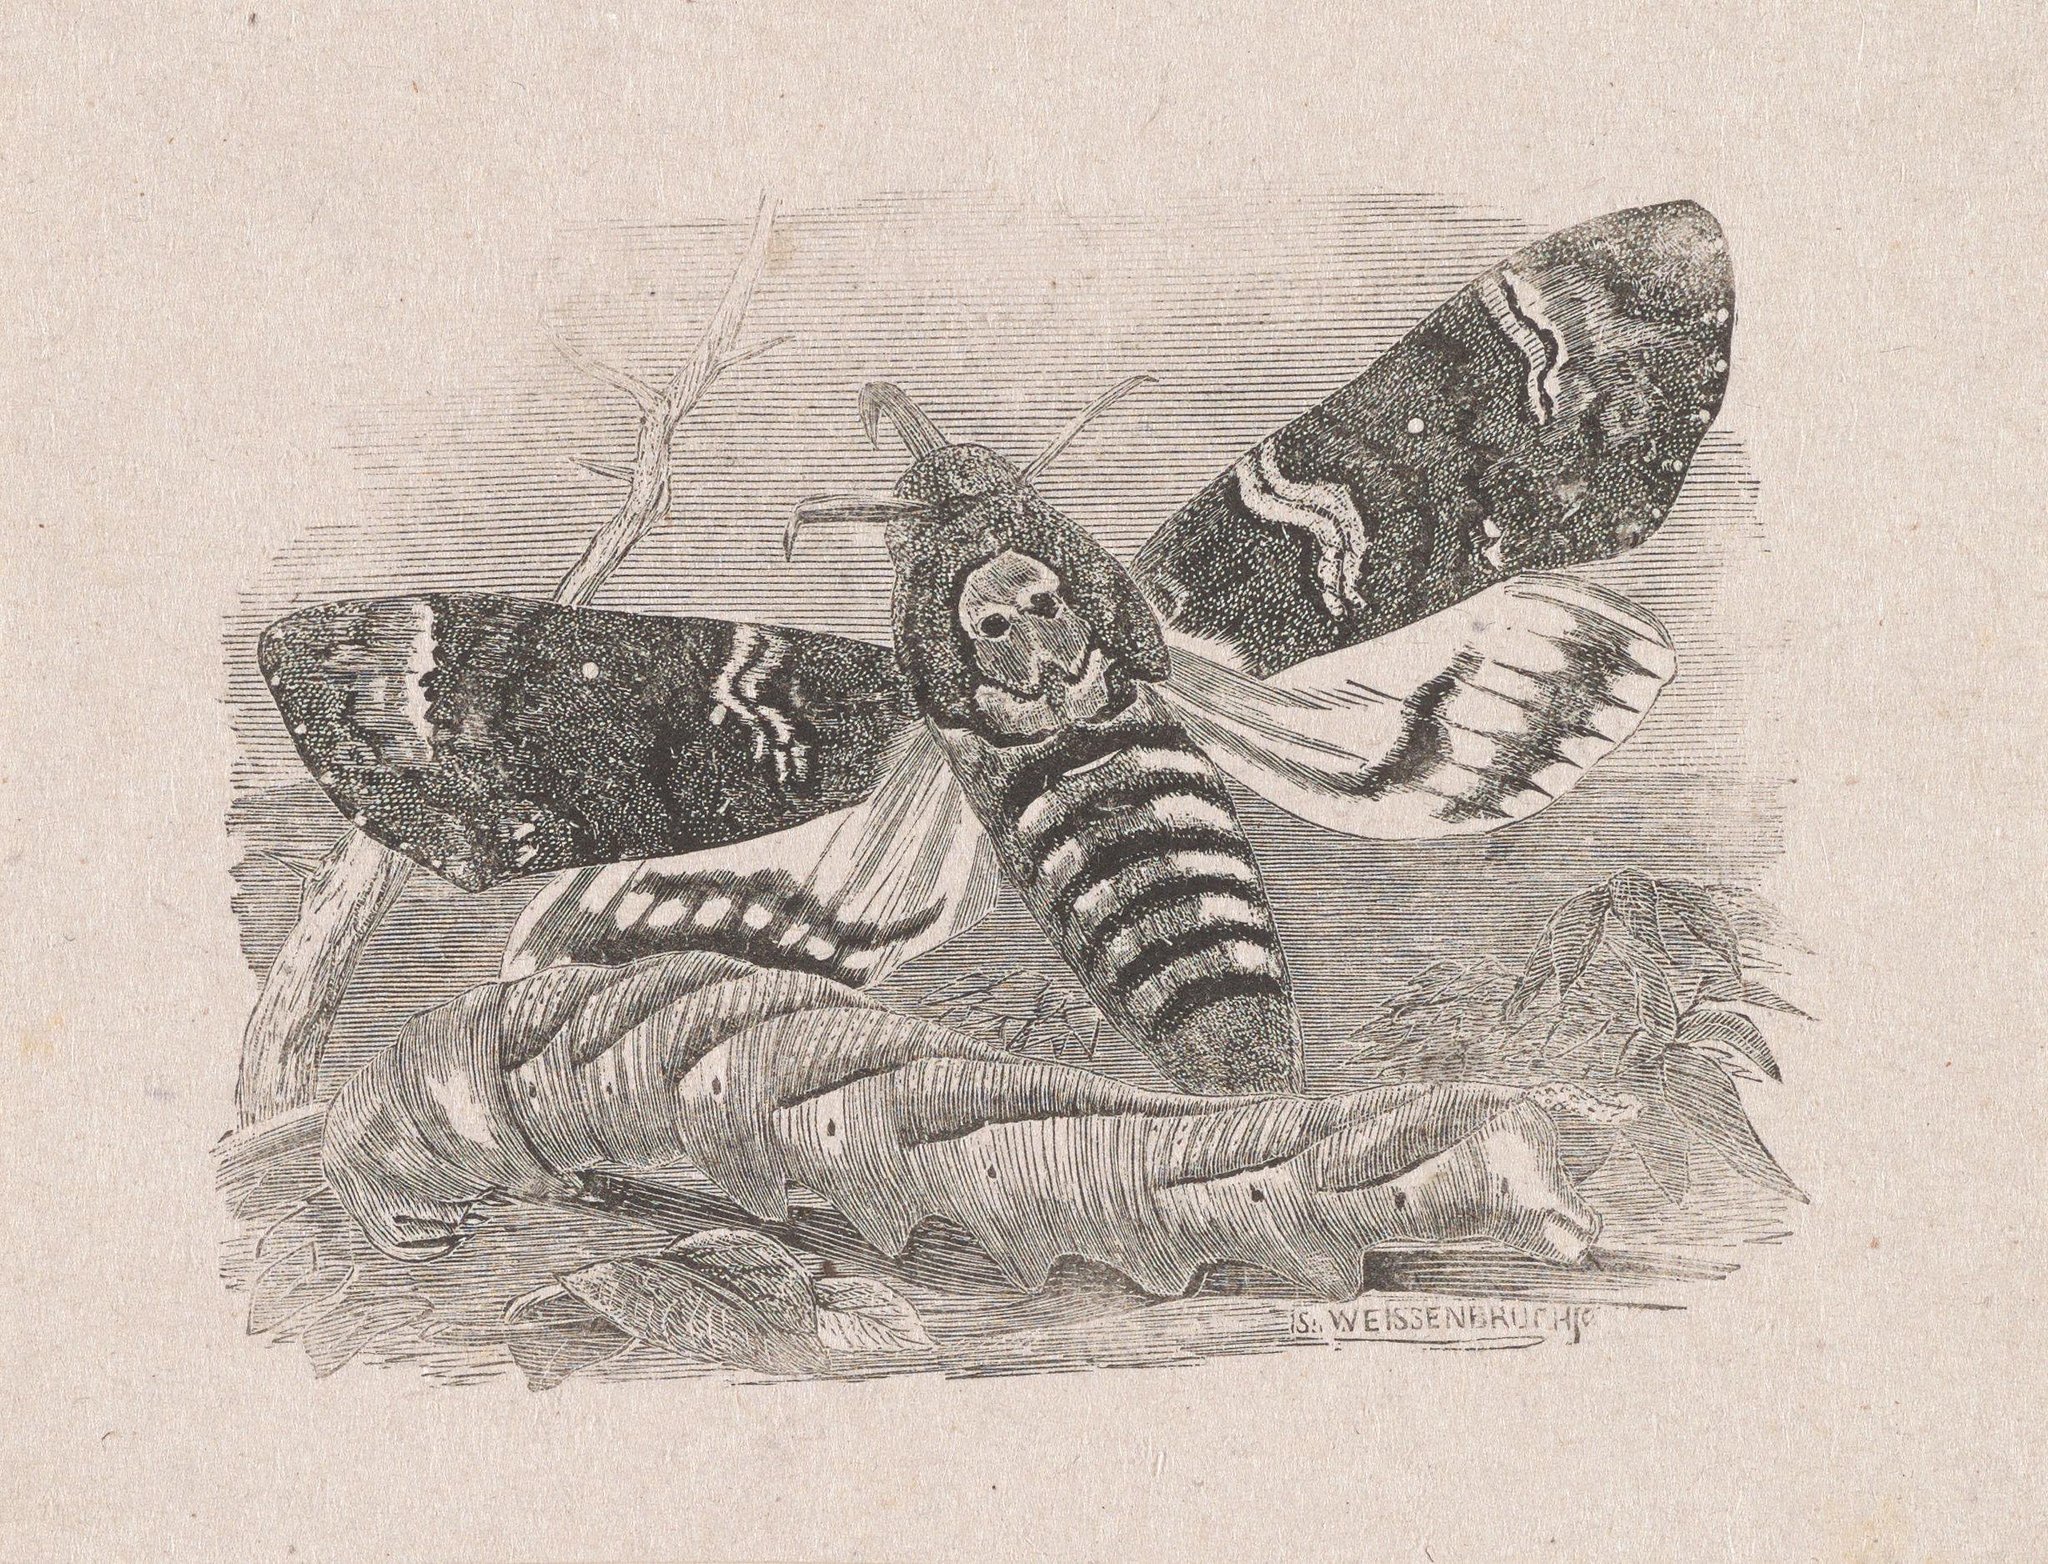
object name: print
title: Doodshoofdvlinder in de stadia rups en vlinder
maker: isaac weissenbruch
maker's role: print maker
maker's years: 1826-1912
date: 1836-1912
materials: paper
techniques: engraving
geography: netherlands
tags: insects: butterfly, insects: caterpillar